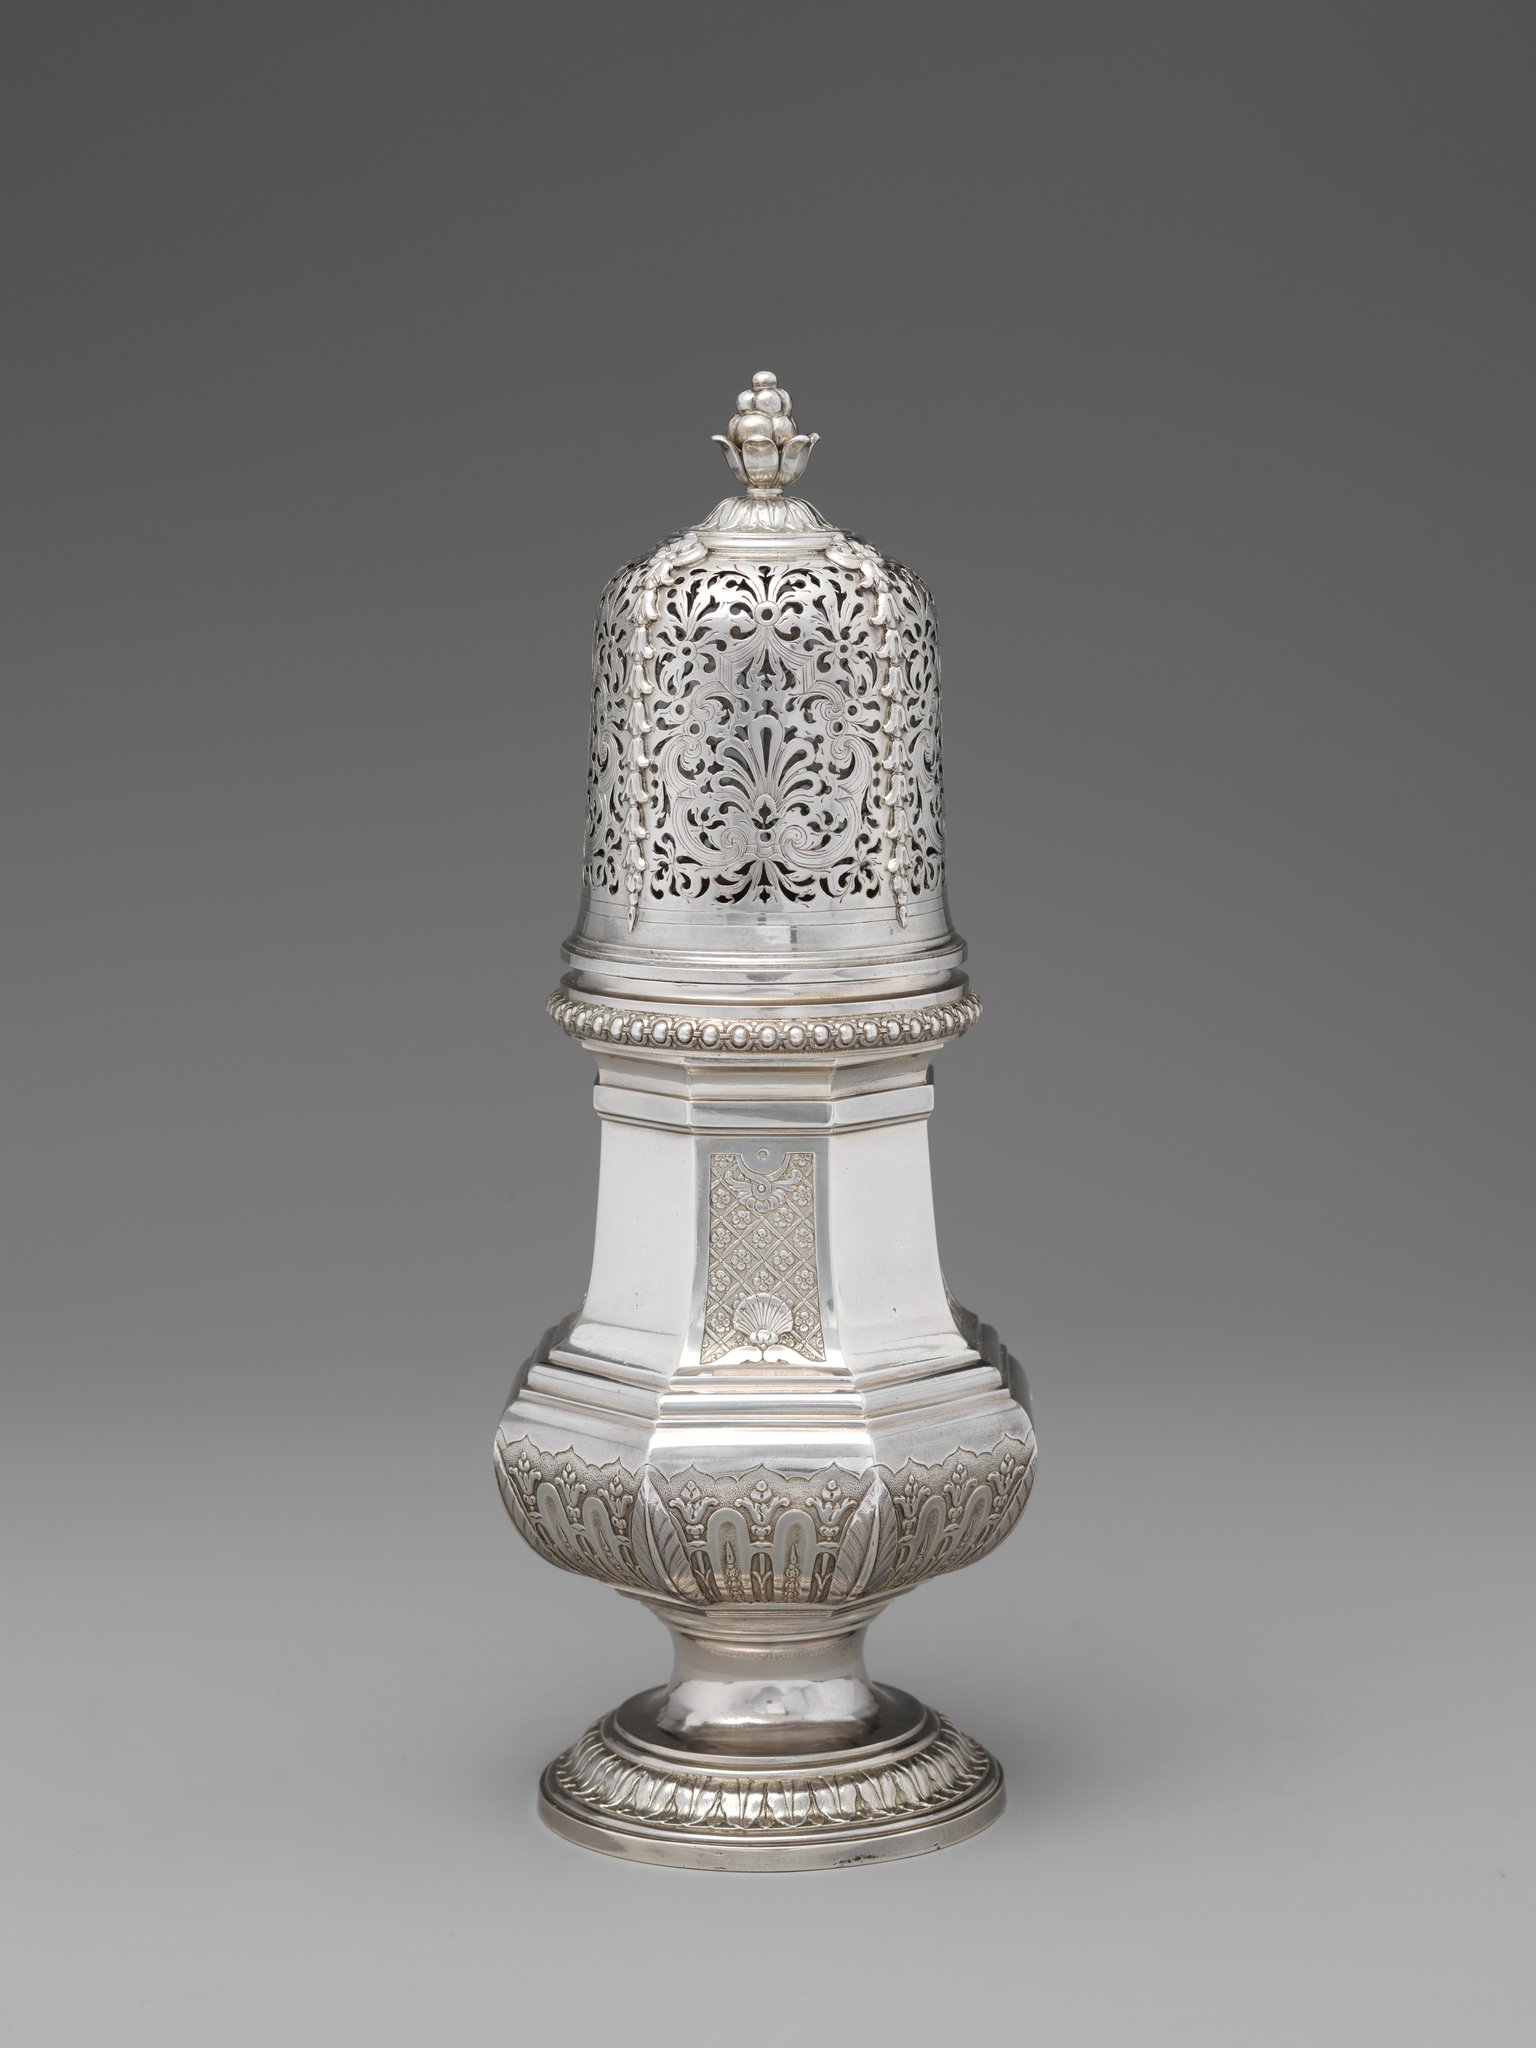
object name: sugar caster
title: Sugar caster (one of a pair)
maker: nicolas besnier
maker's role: maker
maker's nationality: french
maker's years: 1686-1754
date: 1728-1729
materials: silver